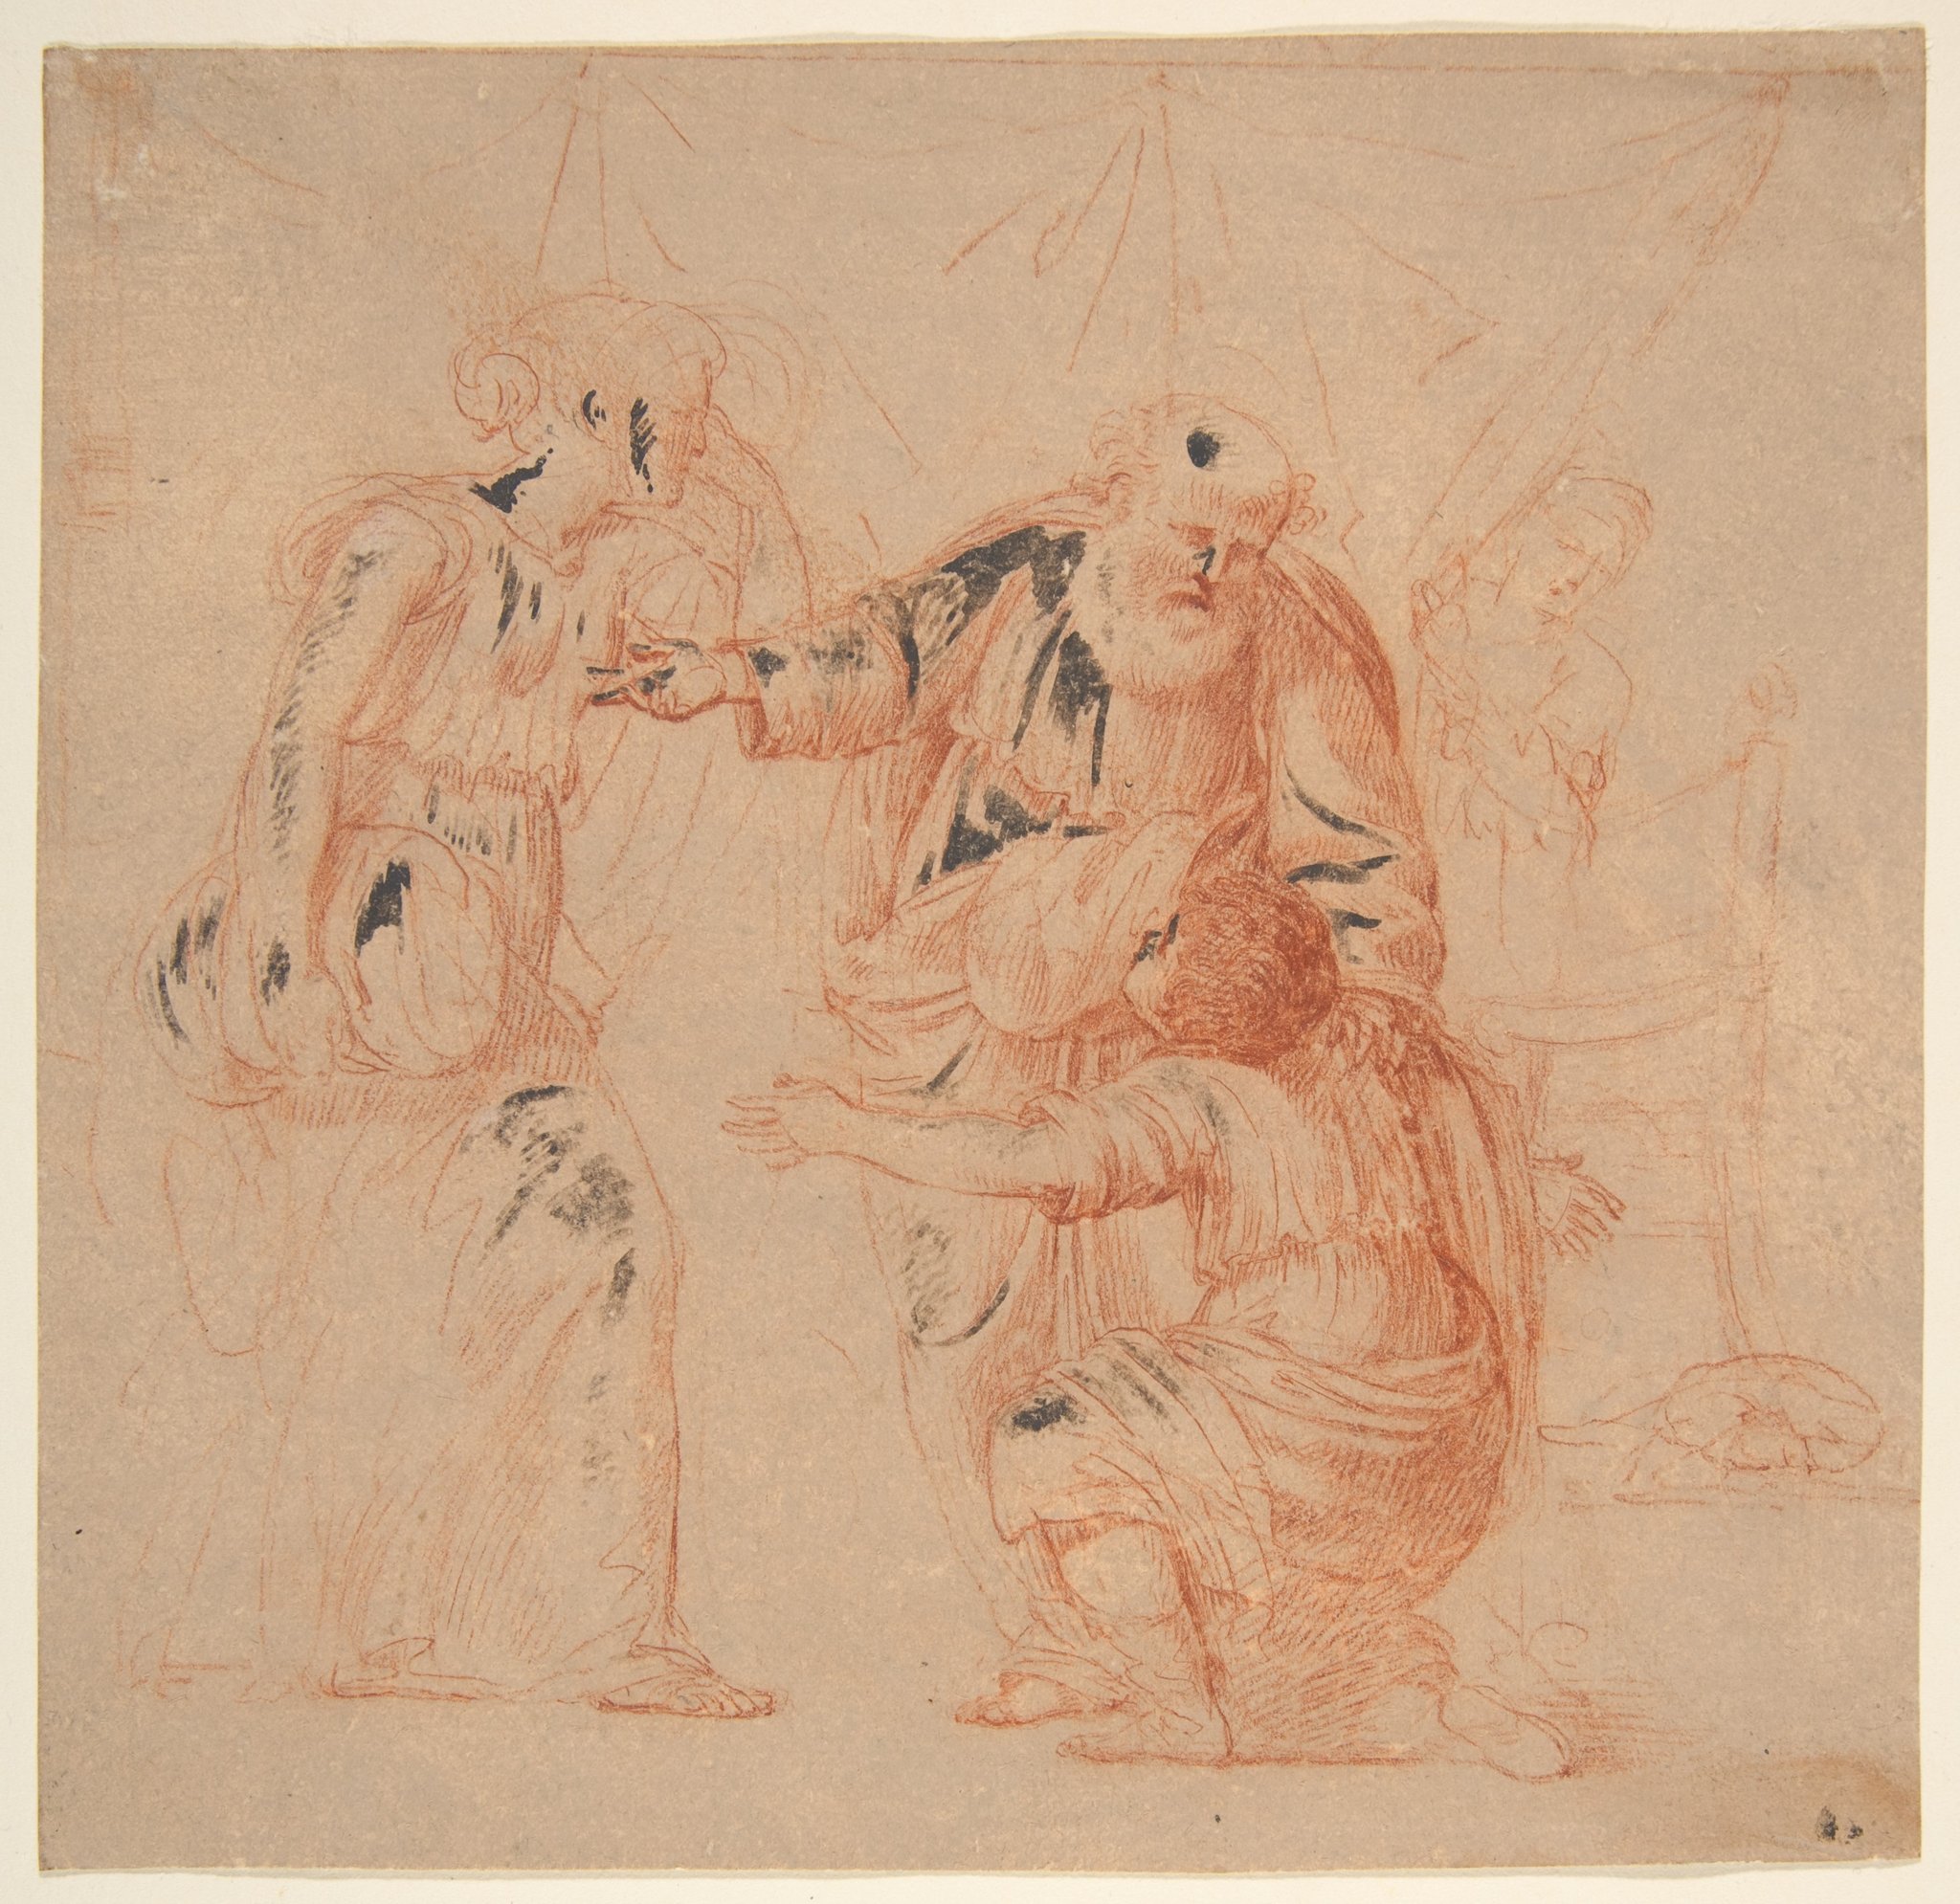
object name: drawing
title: Abraham Dismissing Hagar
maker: andrea sacchi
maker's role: artist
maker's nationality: italian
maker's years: 1599-1661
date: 1599-1661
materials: chalk, lead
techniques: highlighting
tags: boys,women,abraham